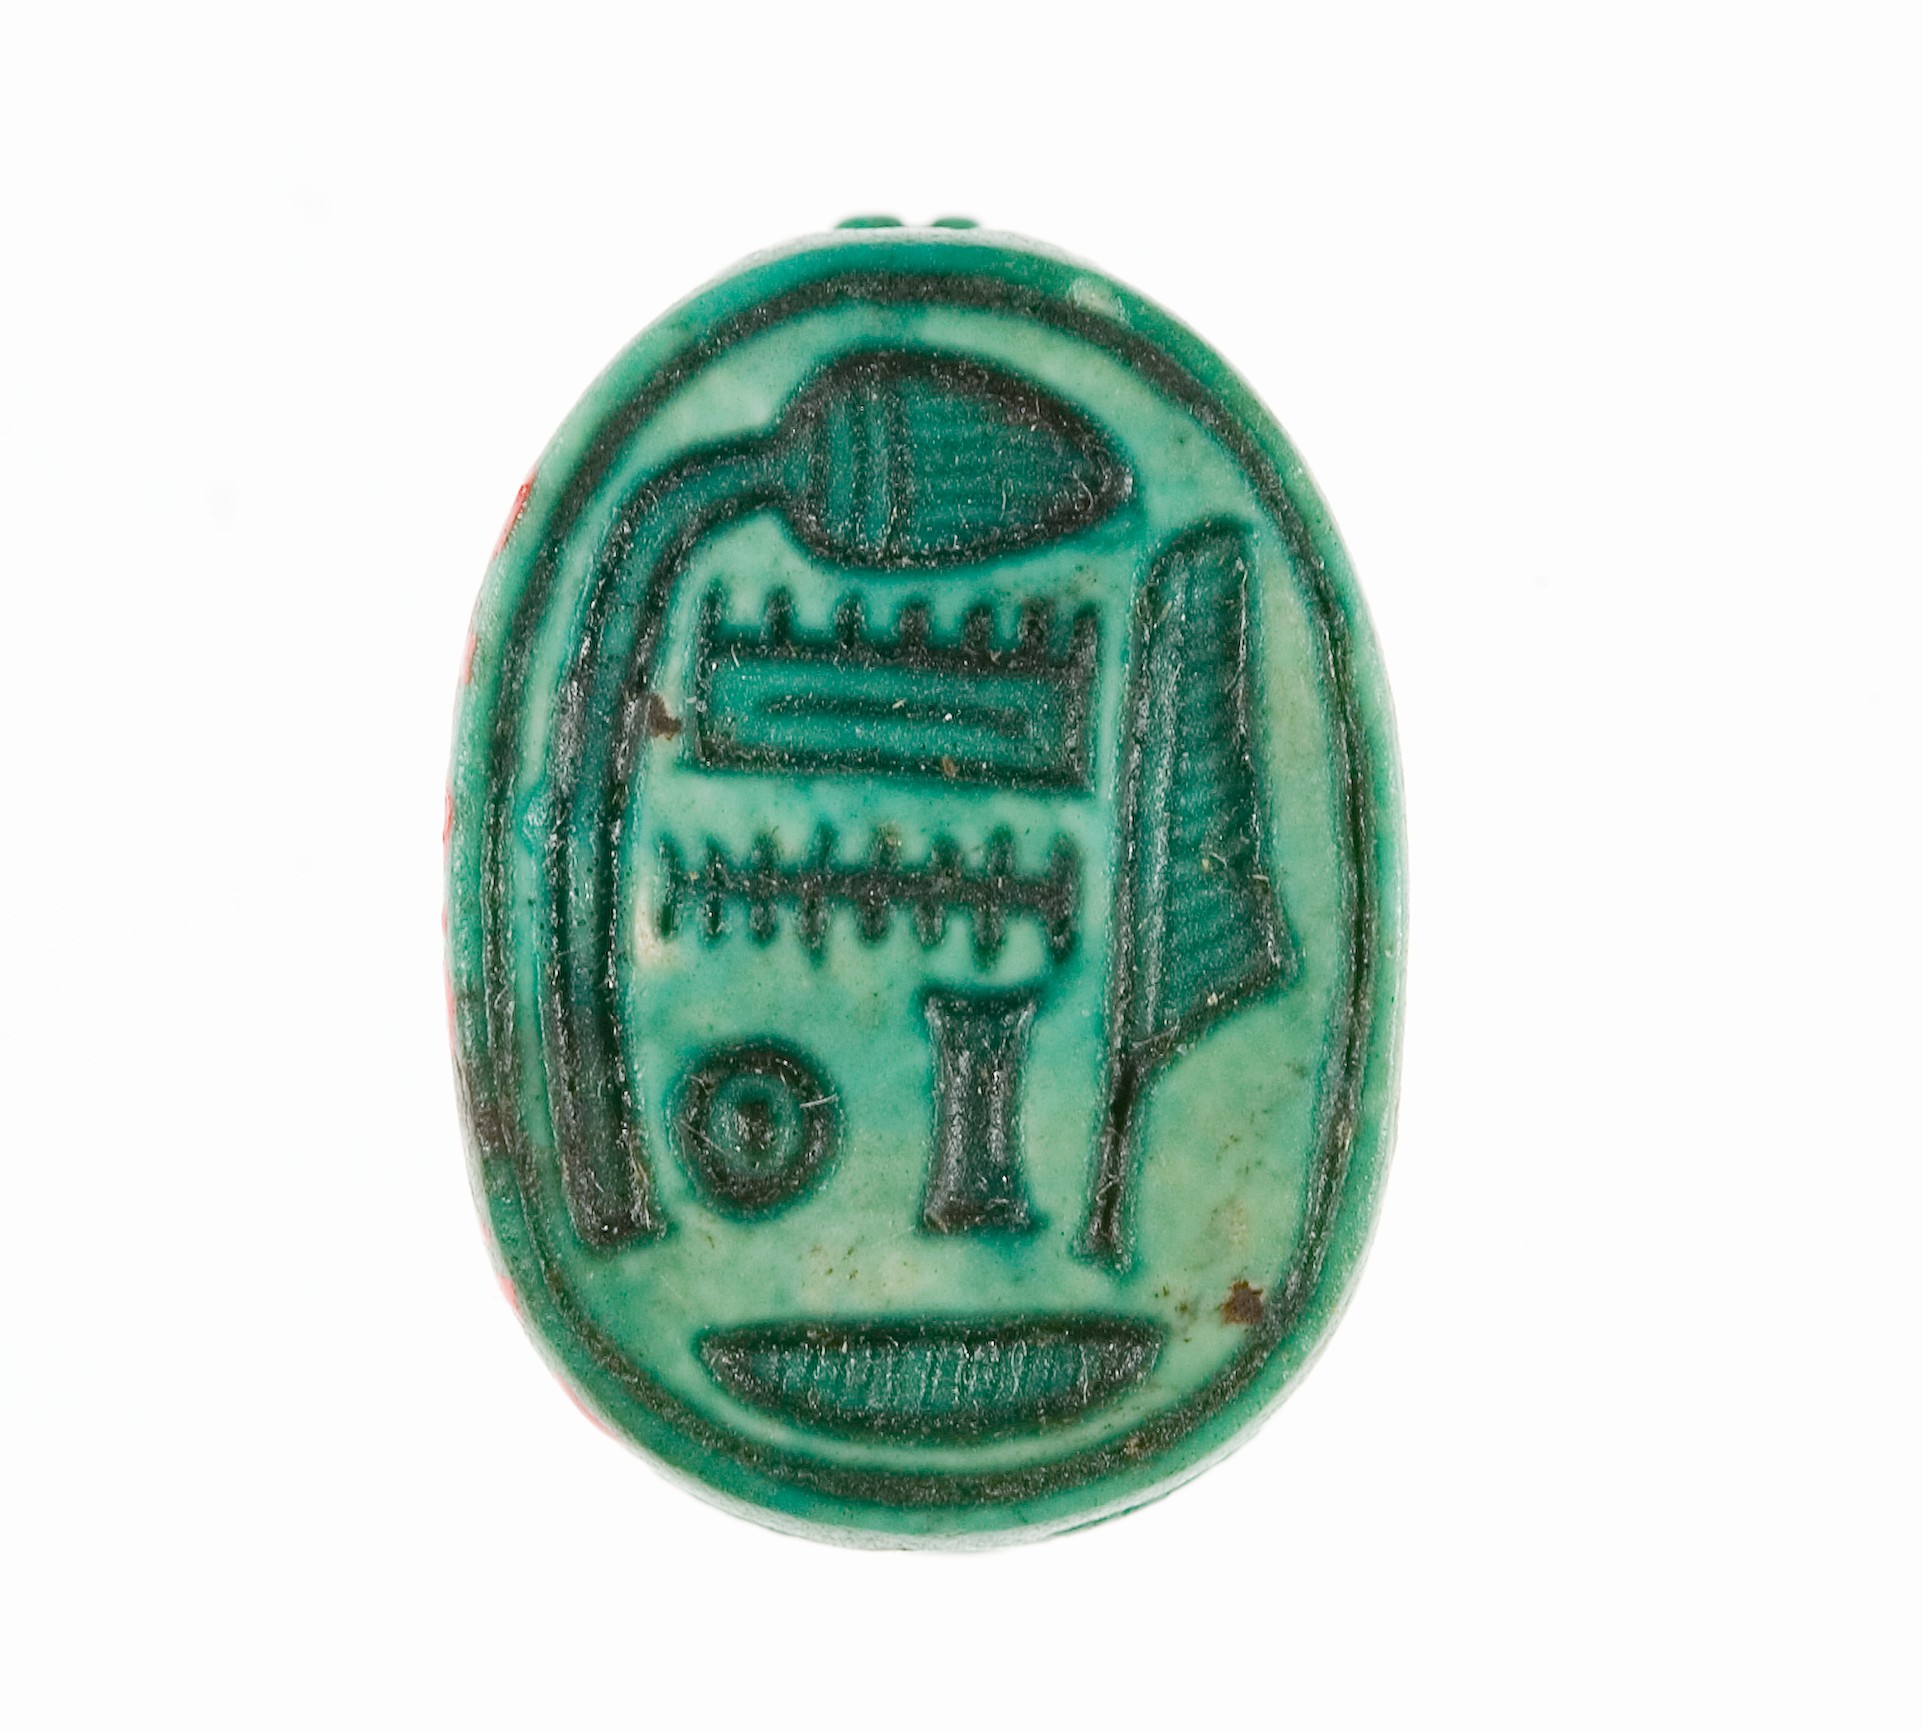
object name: scarab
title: Scarab Inscribed with the Name of the God Amun-Re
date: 1479-1458 BCE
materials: stone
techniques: glazing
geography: egypt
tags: hieroglyphs,scarabs